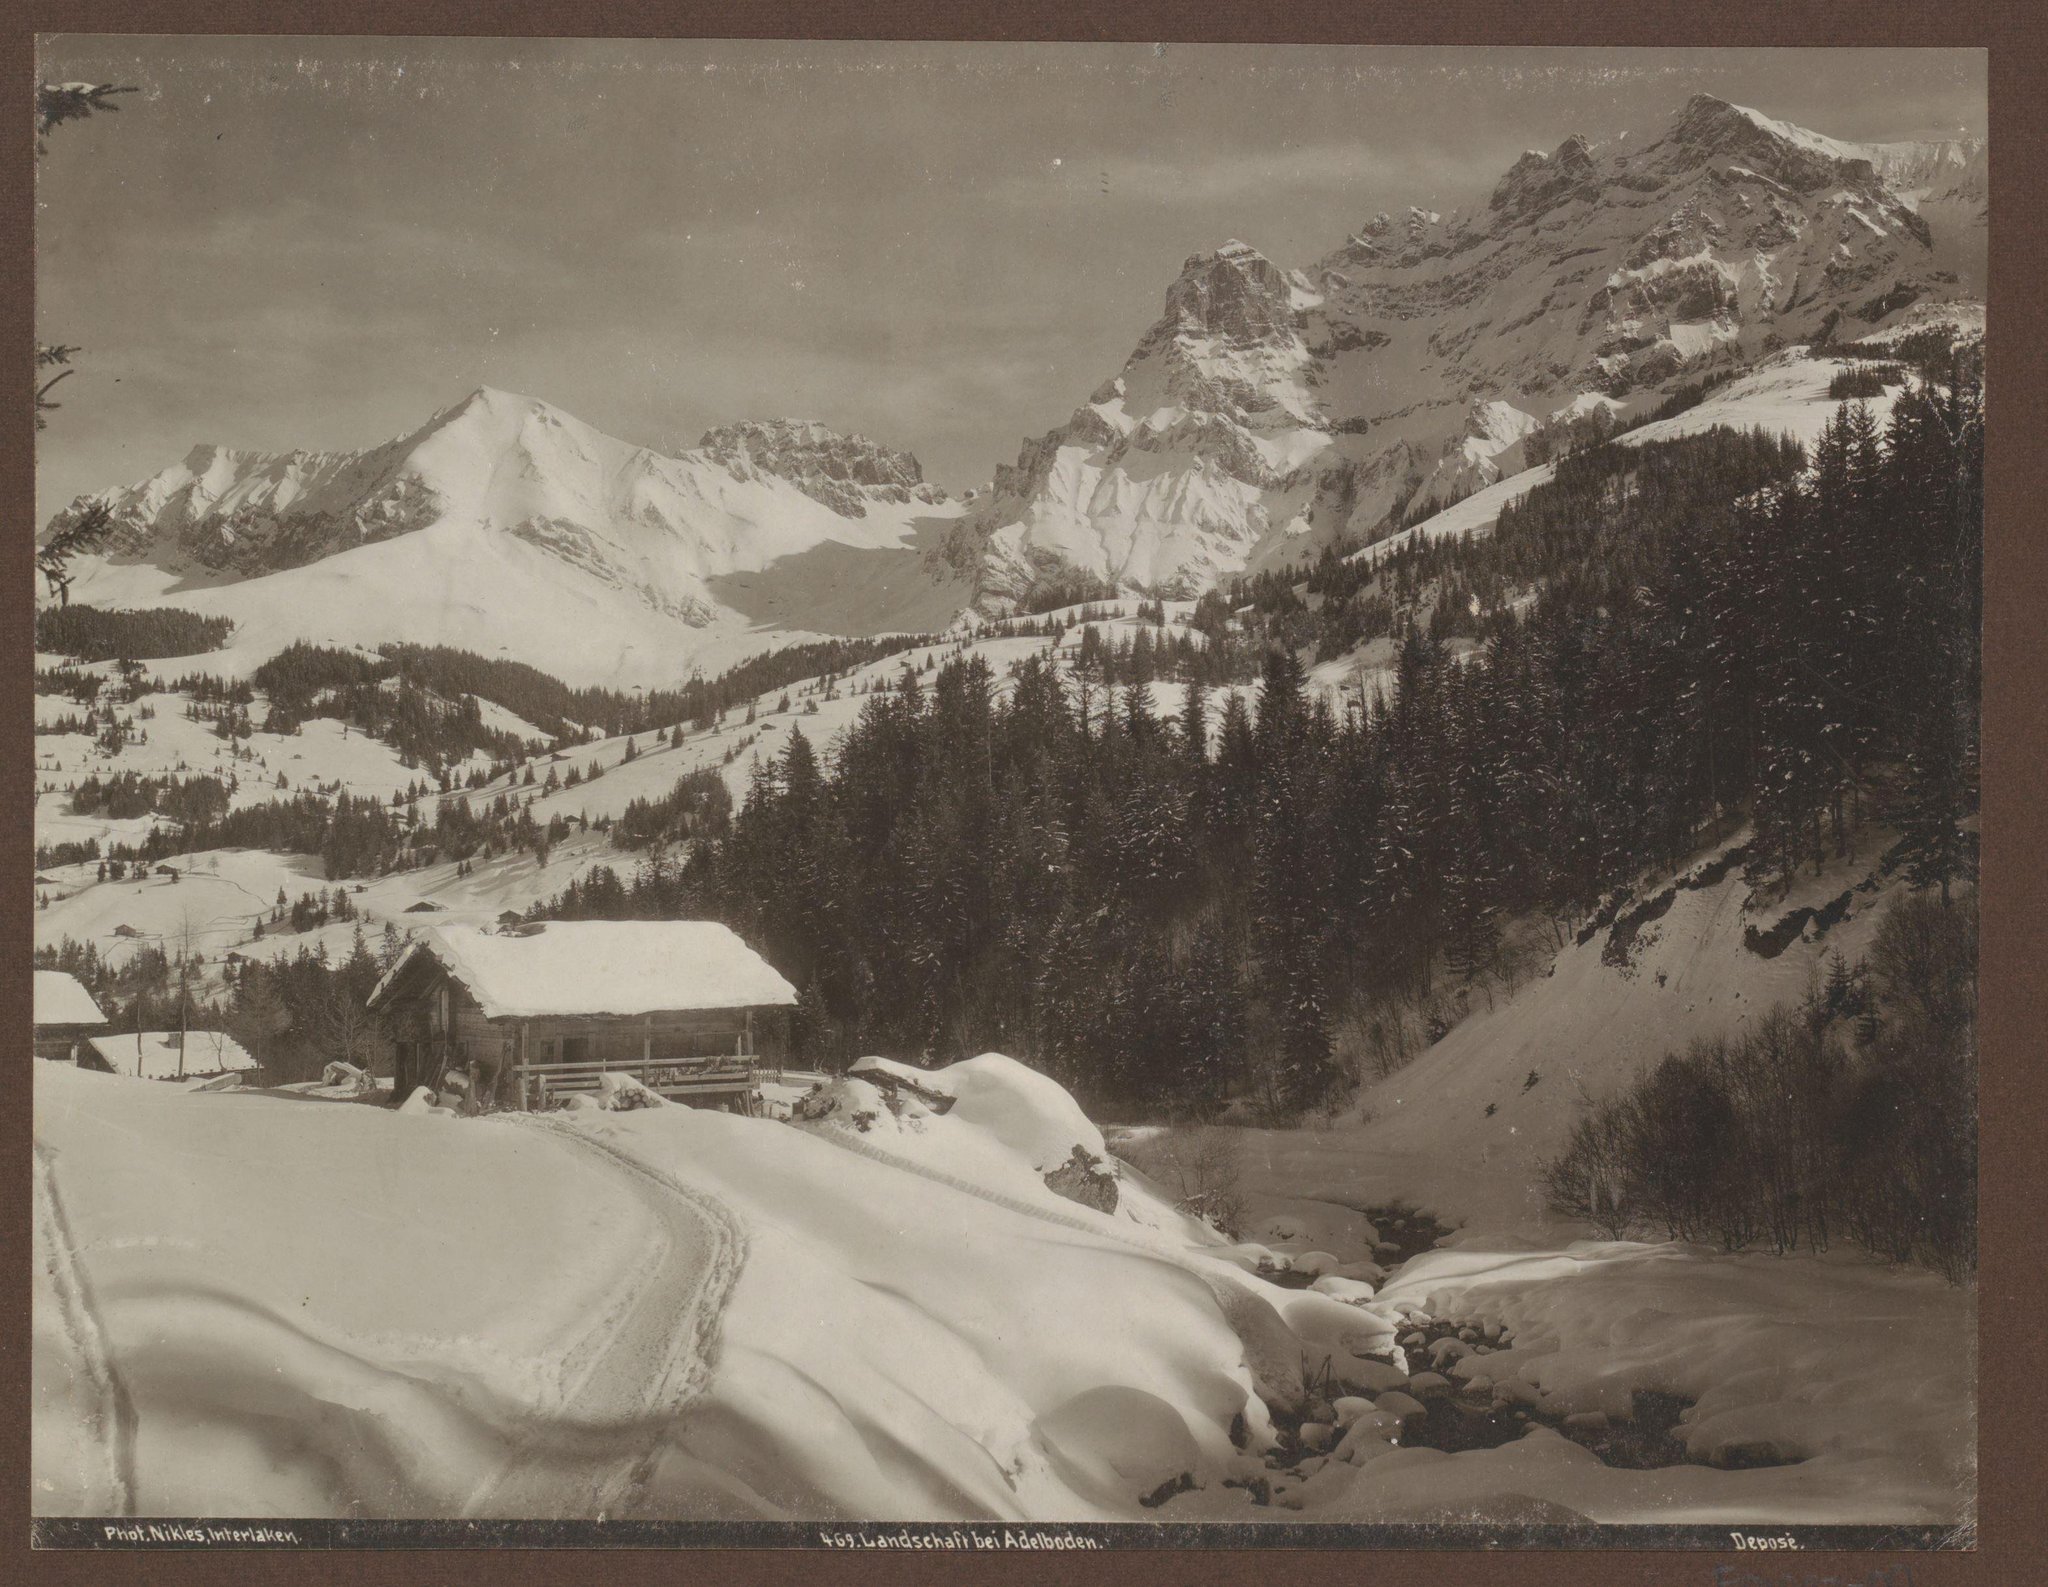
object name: photograph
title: Landschaft bei Adelboden.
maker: nikles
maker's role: fotograaf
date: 1880-1900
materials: paper, photographic support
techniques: gelatin silver print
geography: adelboden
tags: mountain-top, peak (+ landscape with figures, staffage)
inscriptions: negative number: ‘469’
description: Onderdeel van Reisalbum met foto's van Duitsland, Zwitserland, het Suezkanaal en Nederlands-Indië.